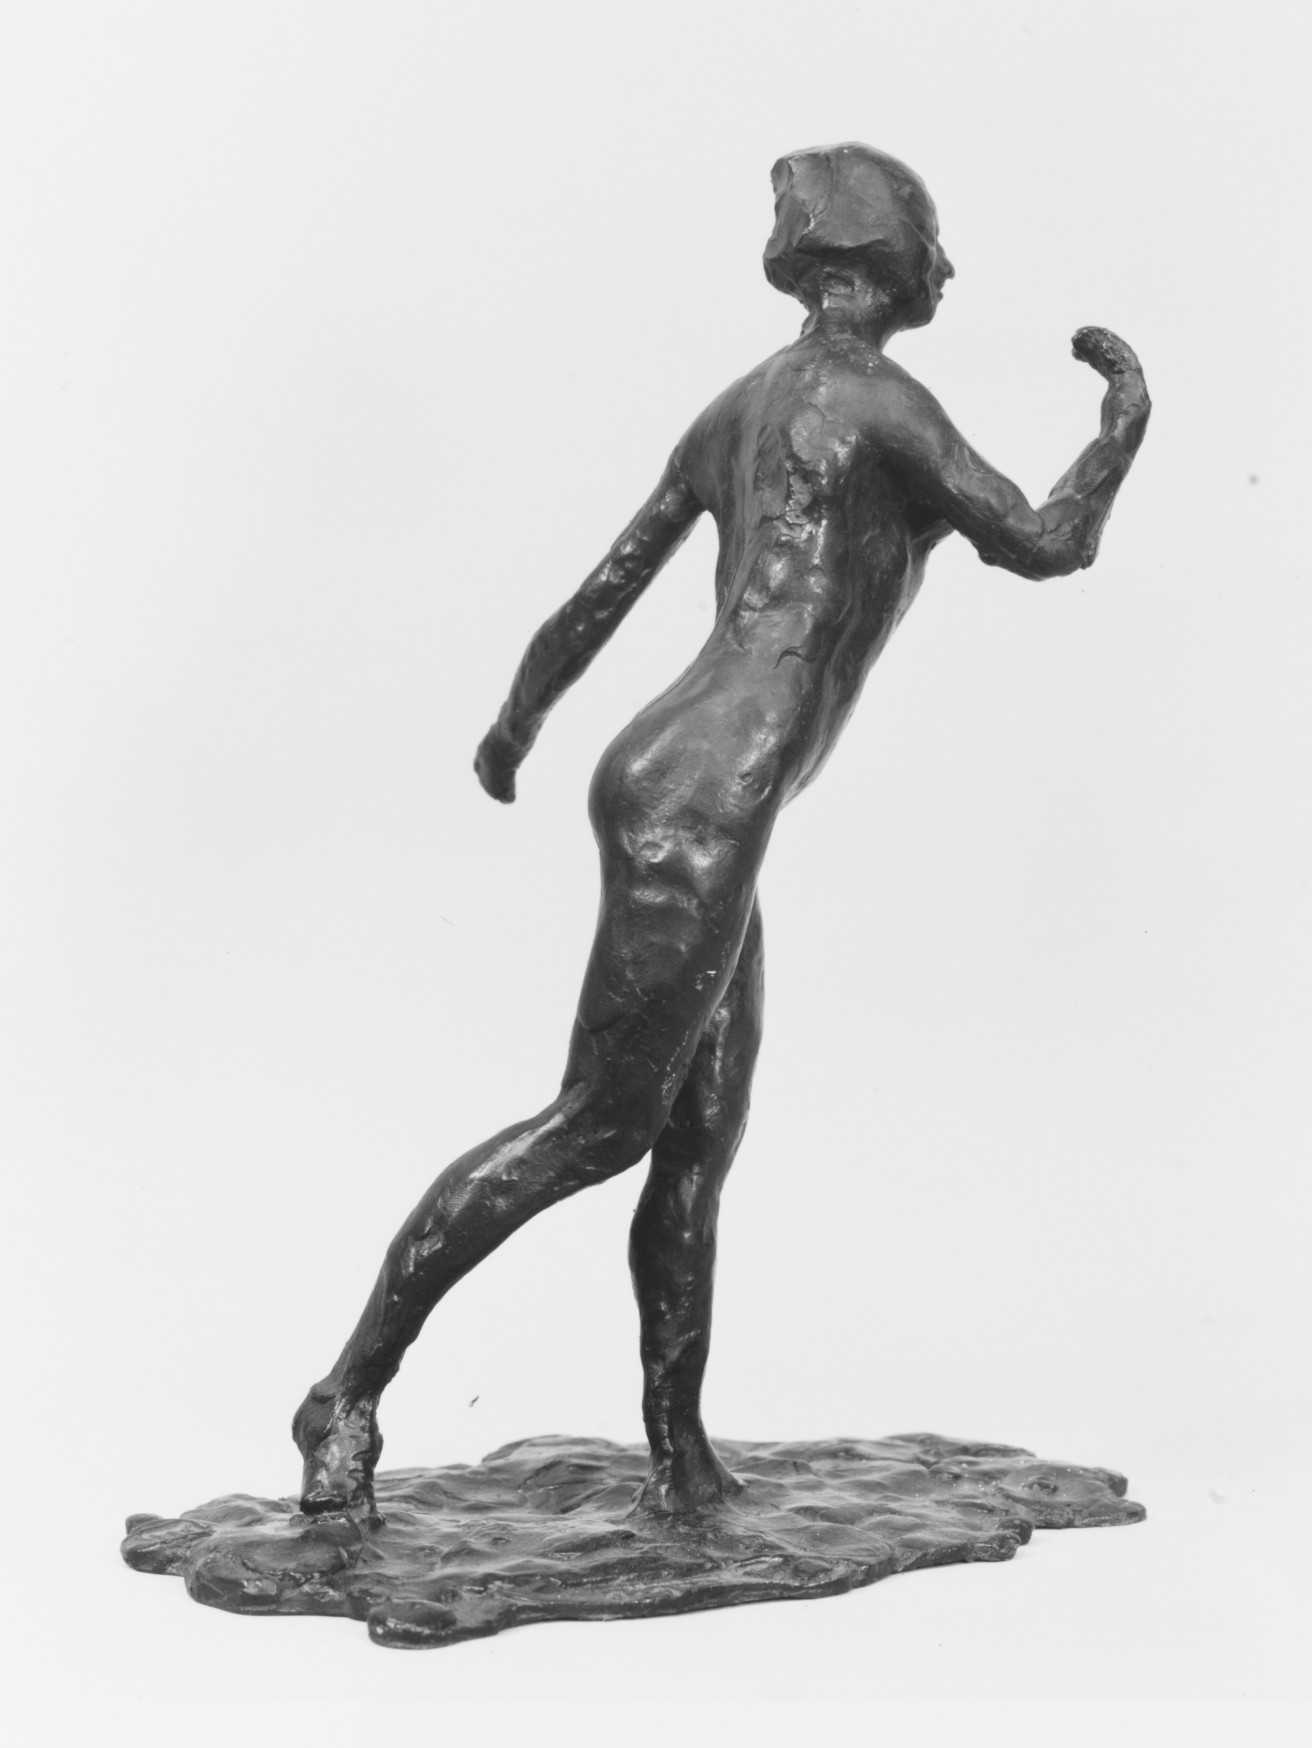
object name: statuette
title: Dancer Bowing (Second State)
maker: edgar degas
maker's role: artist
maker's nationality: french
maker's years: 1834-1917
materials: bronze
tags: female nudes